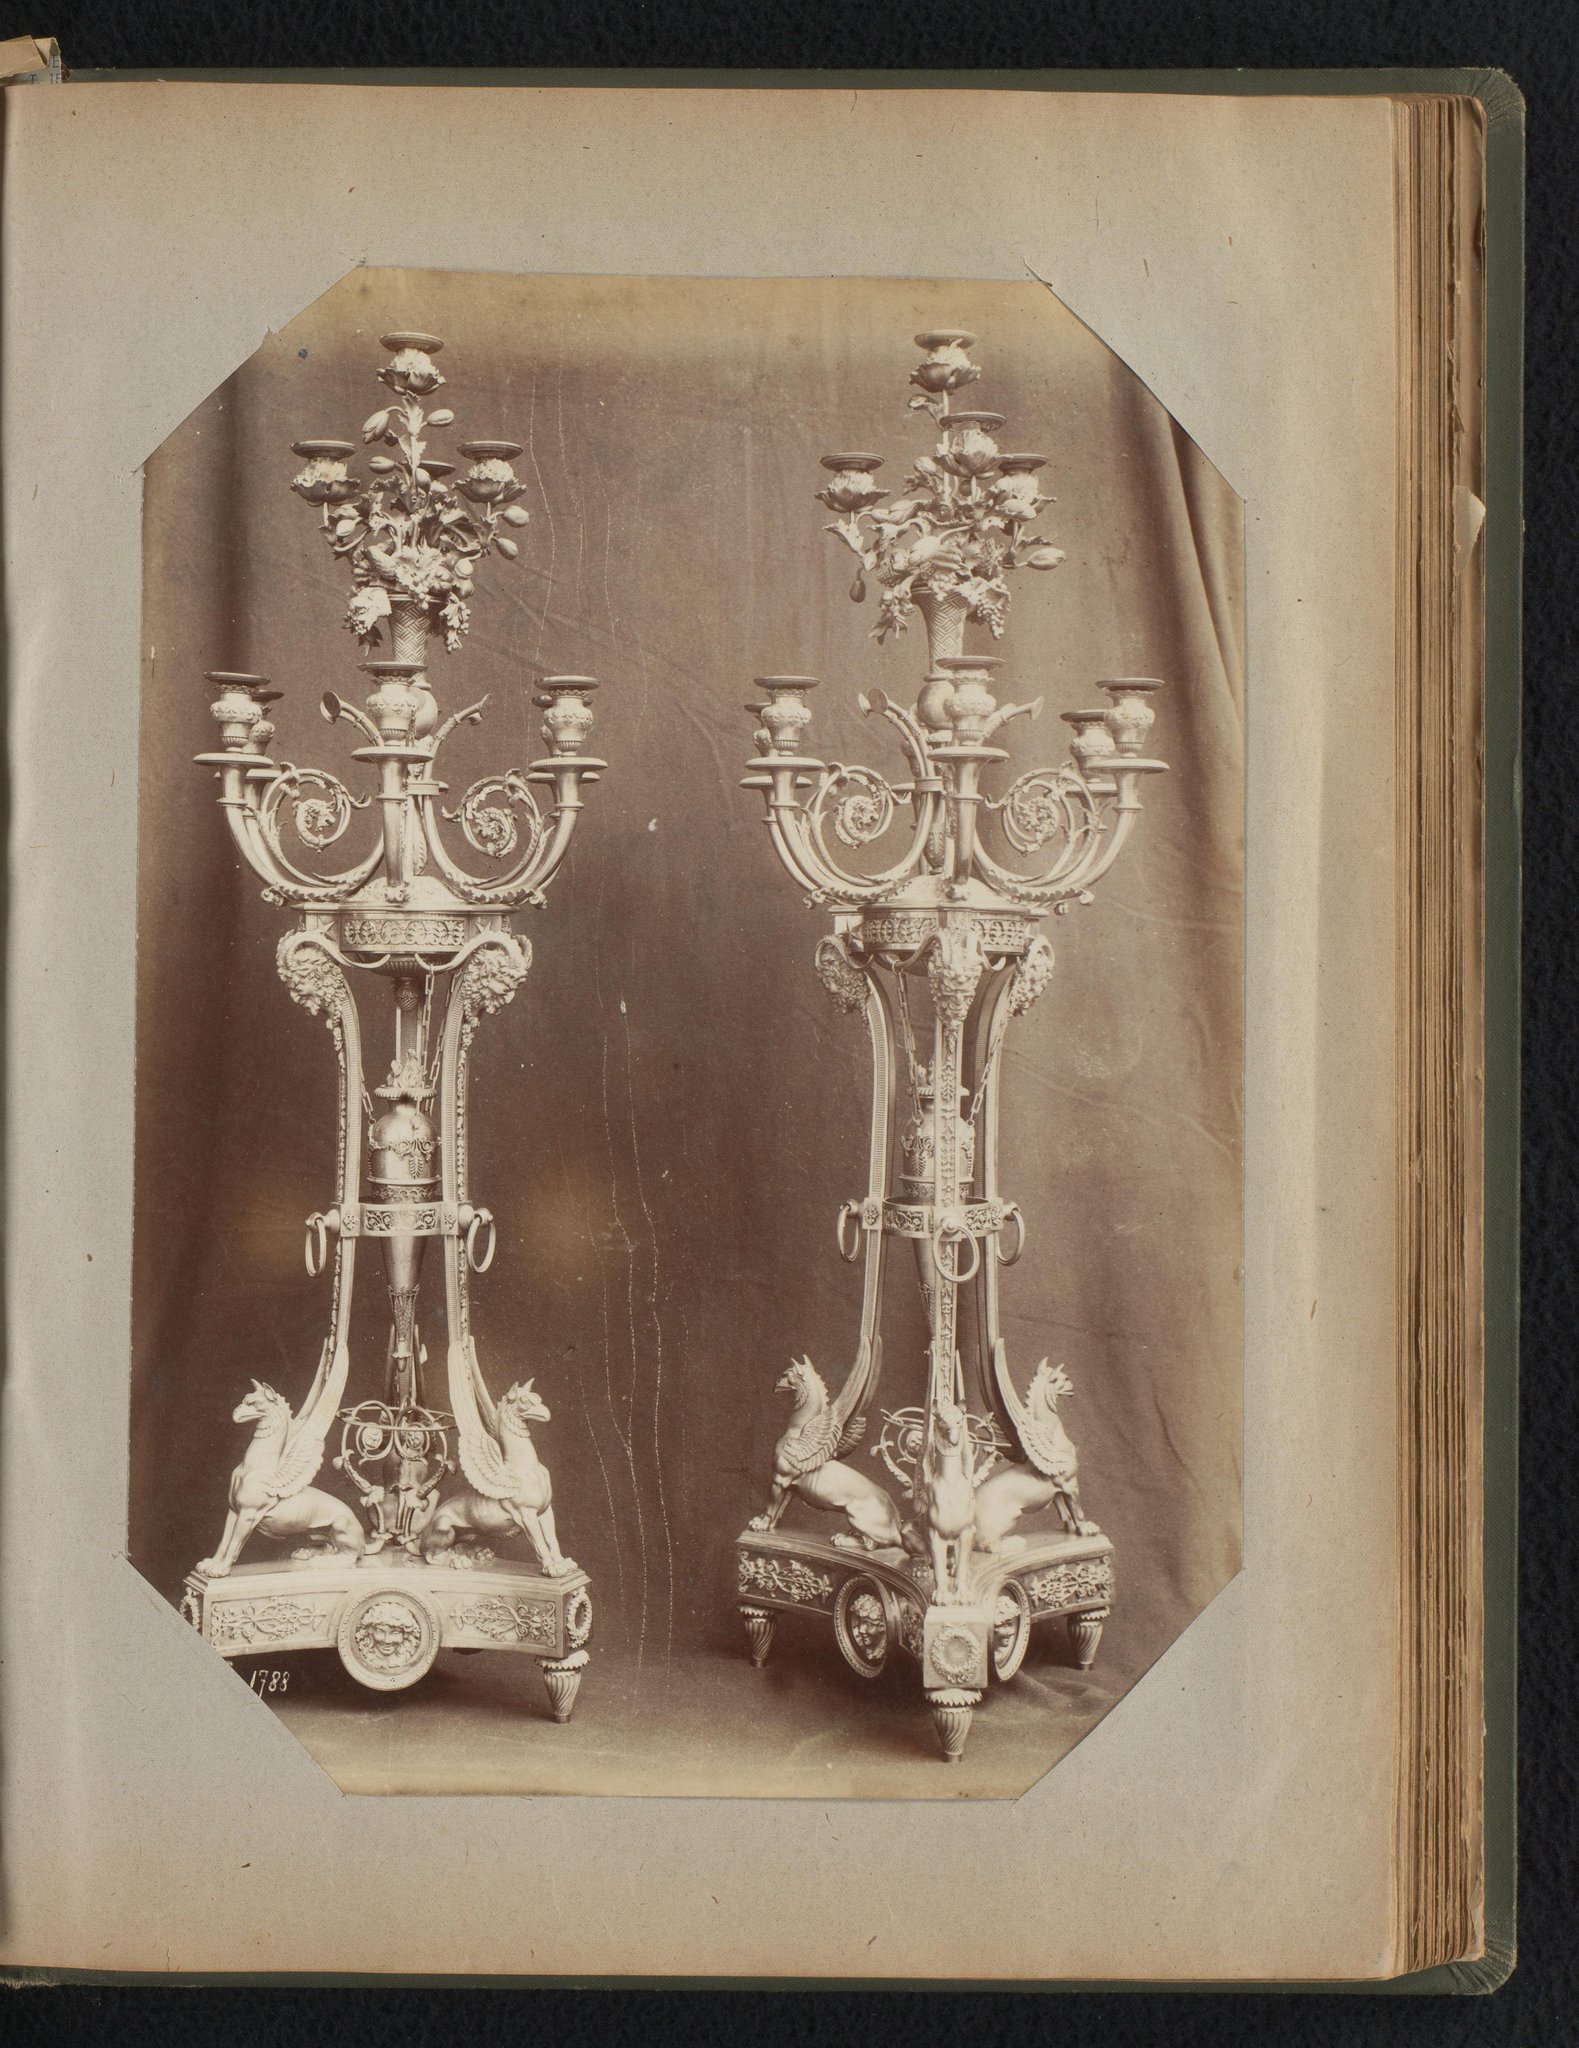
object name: photograph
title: Twee bronzen, gedecoreerde tienarmige kandelaars met bloem en mythologische decoratie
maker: Anonymous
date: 1860-1900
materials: canvas, cardboard, paper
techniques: albumen print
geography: netherlands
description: Aan de voet van de kandelaars zijn griffioenen aangebracht, boven aan de voet is het hoofd van Pan zichtbaar.